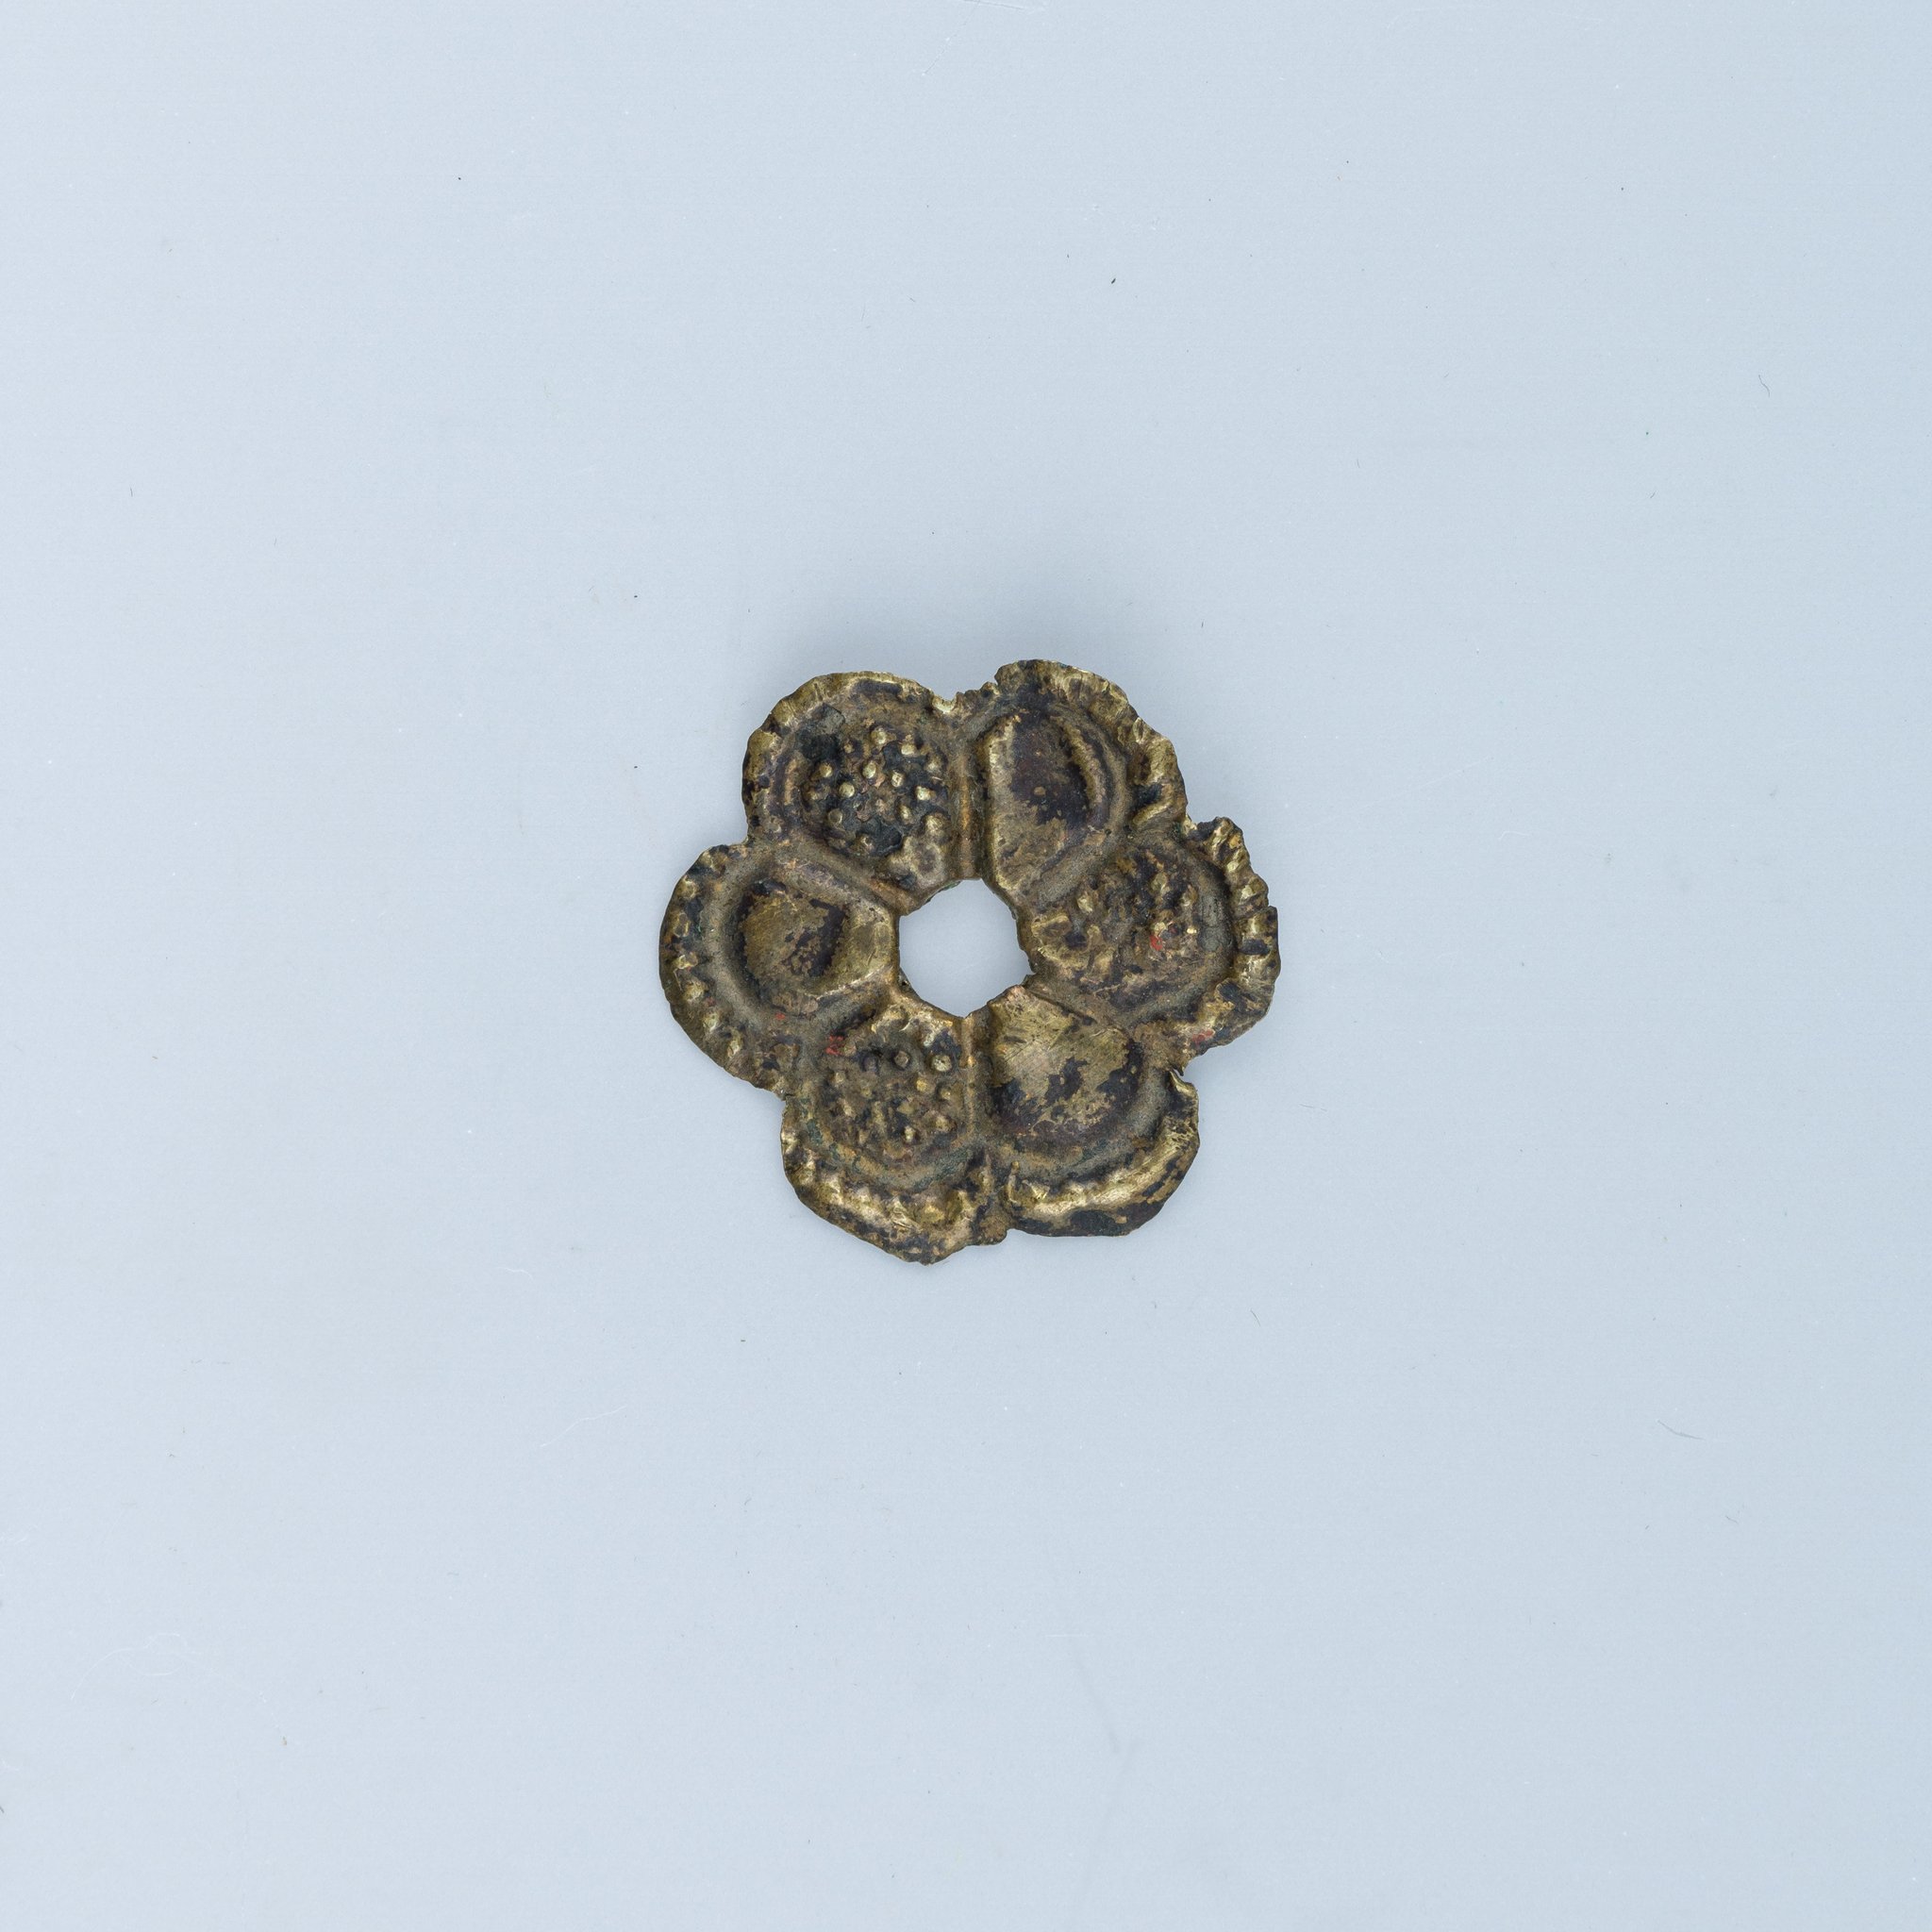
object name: rosette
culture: german, saxony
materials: brass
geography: germany